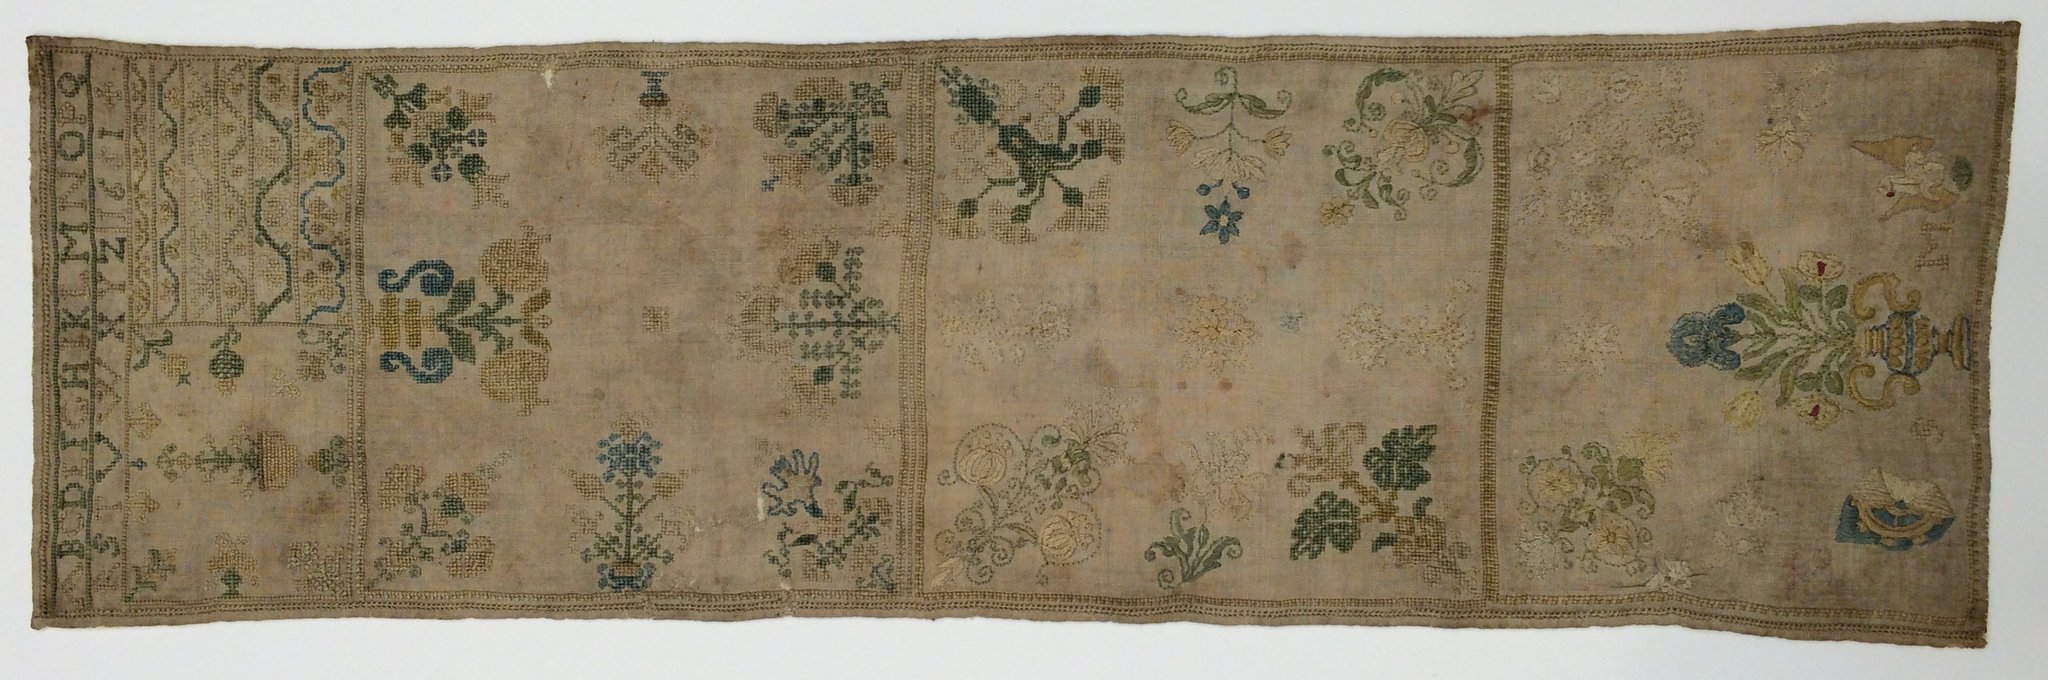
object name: sampler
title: Embroidered sampler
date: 1651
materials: linen, silk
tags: animals,flowers